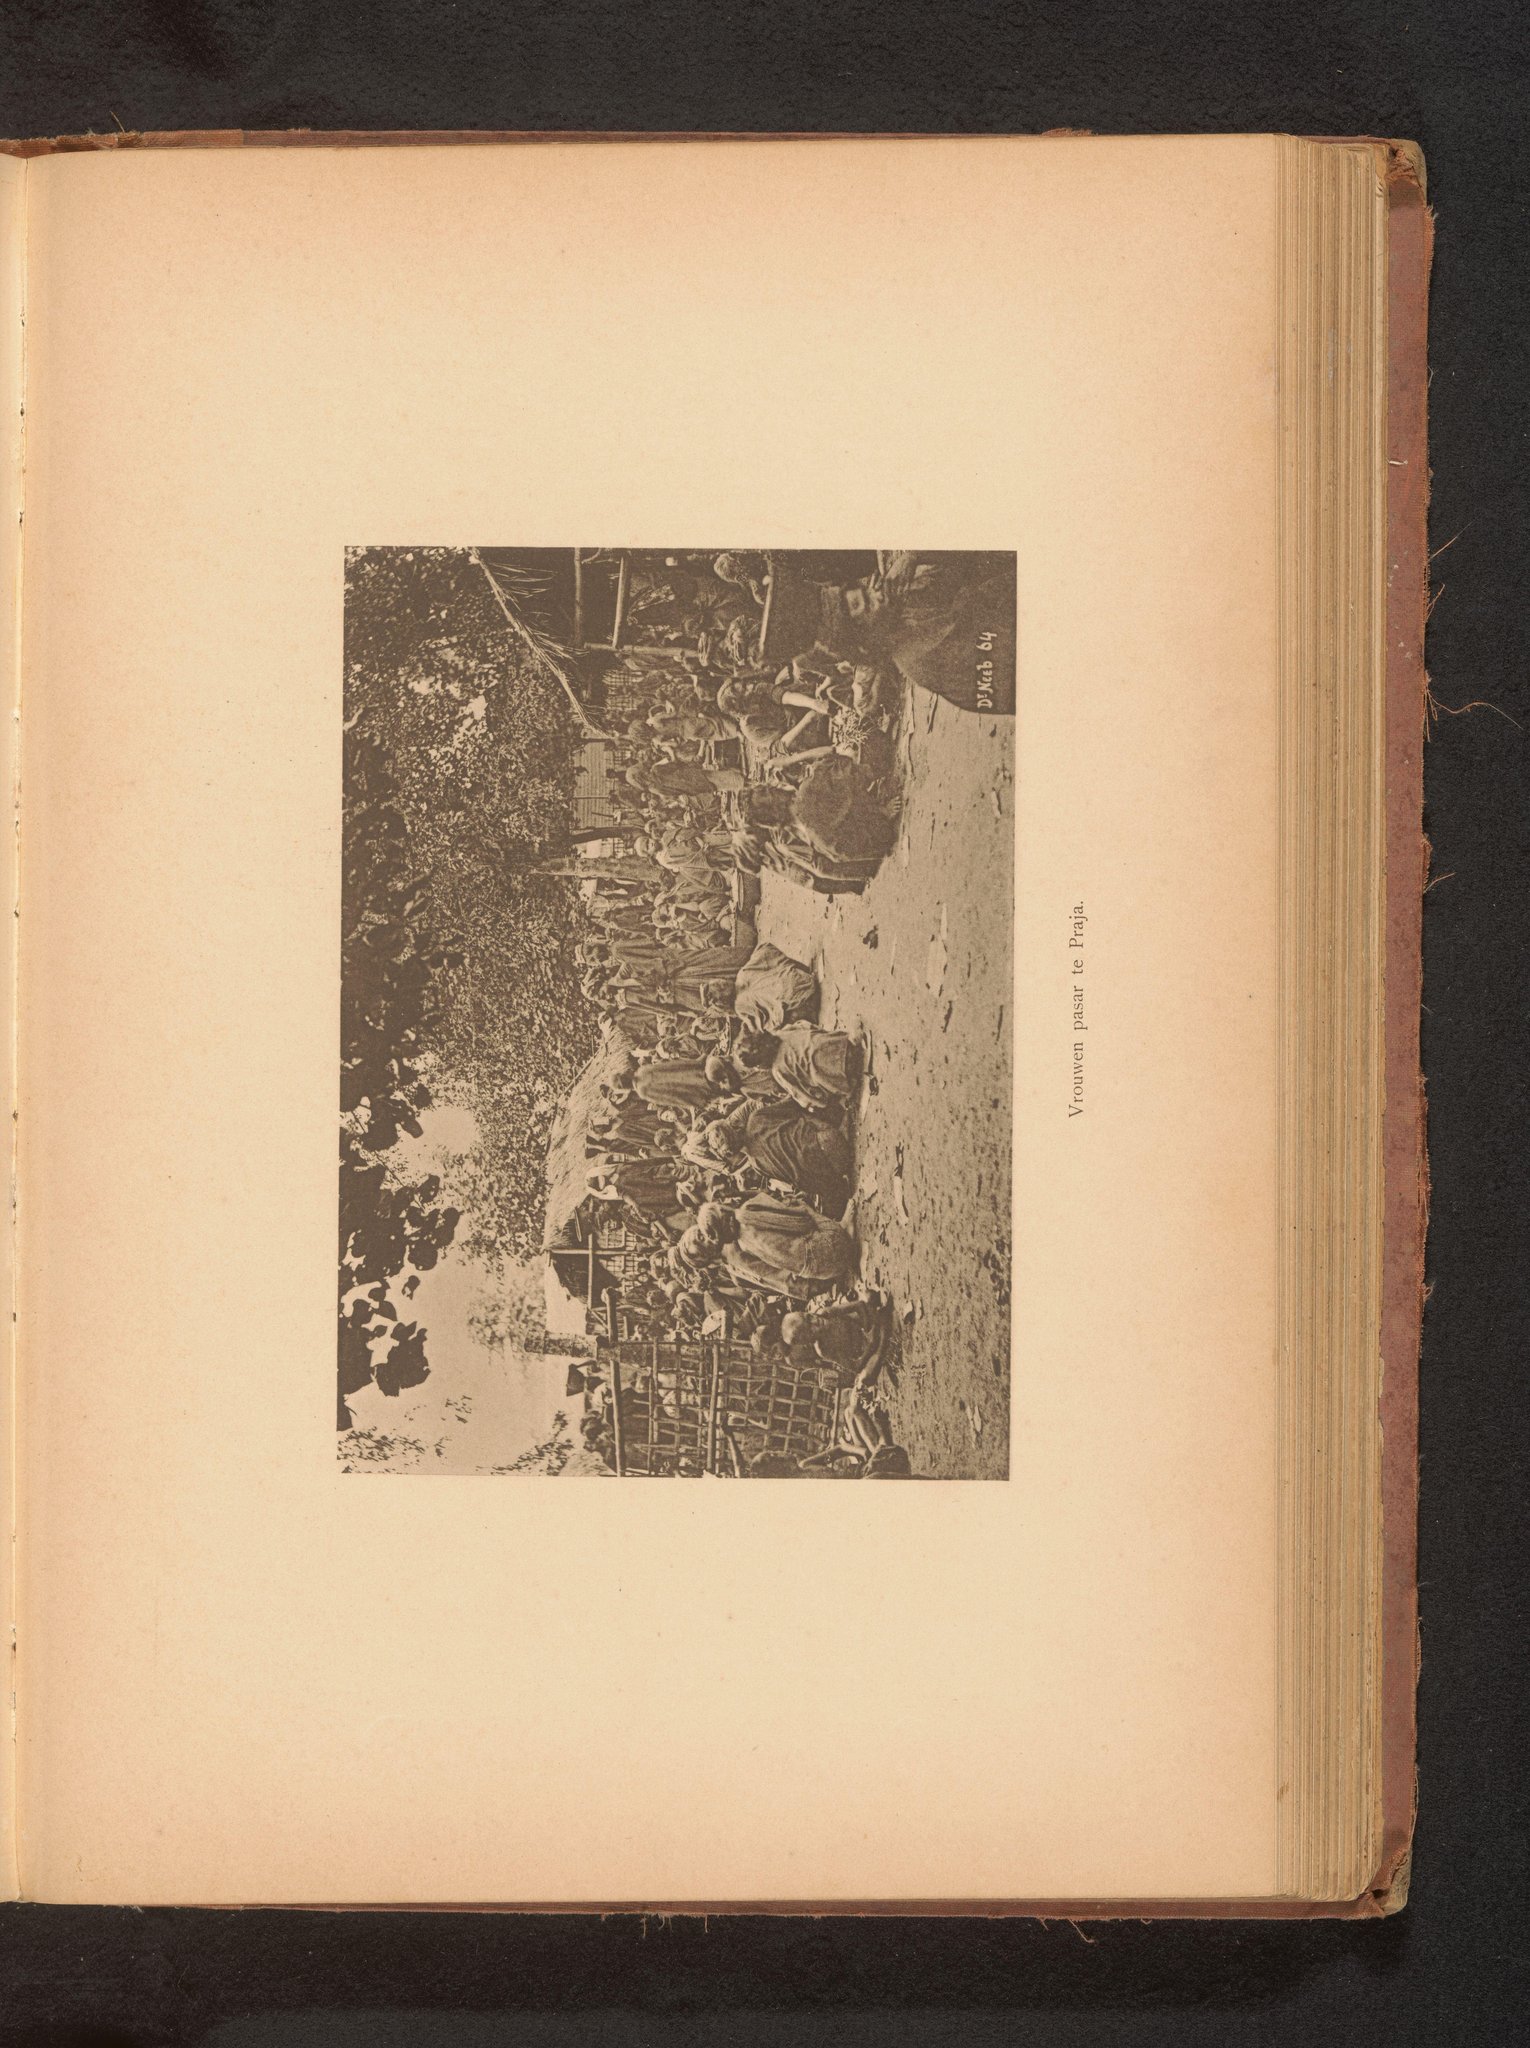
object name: photomechanical print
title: Vrouwen pasar te Praja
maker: christiaan johan neeb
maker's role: arts, fotograaf, officier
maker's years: 1860-1925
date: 1892-1897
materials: paper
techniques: photograph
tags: historical persons, market, indonesia